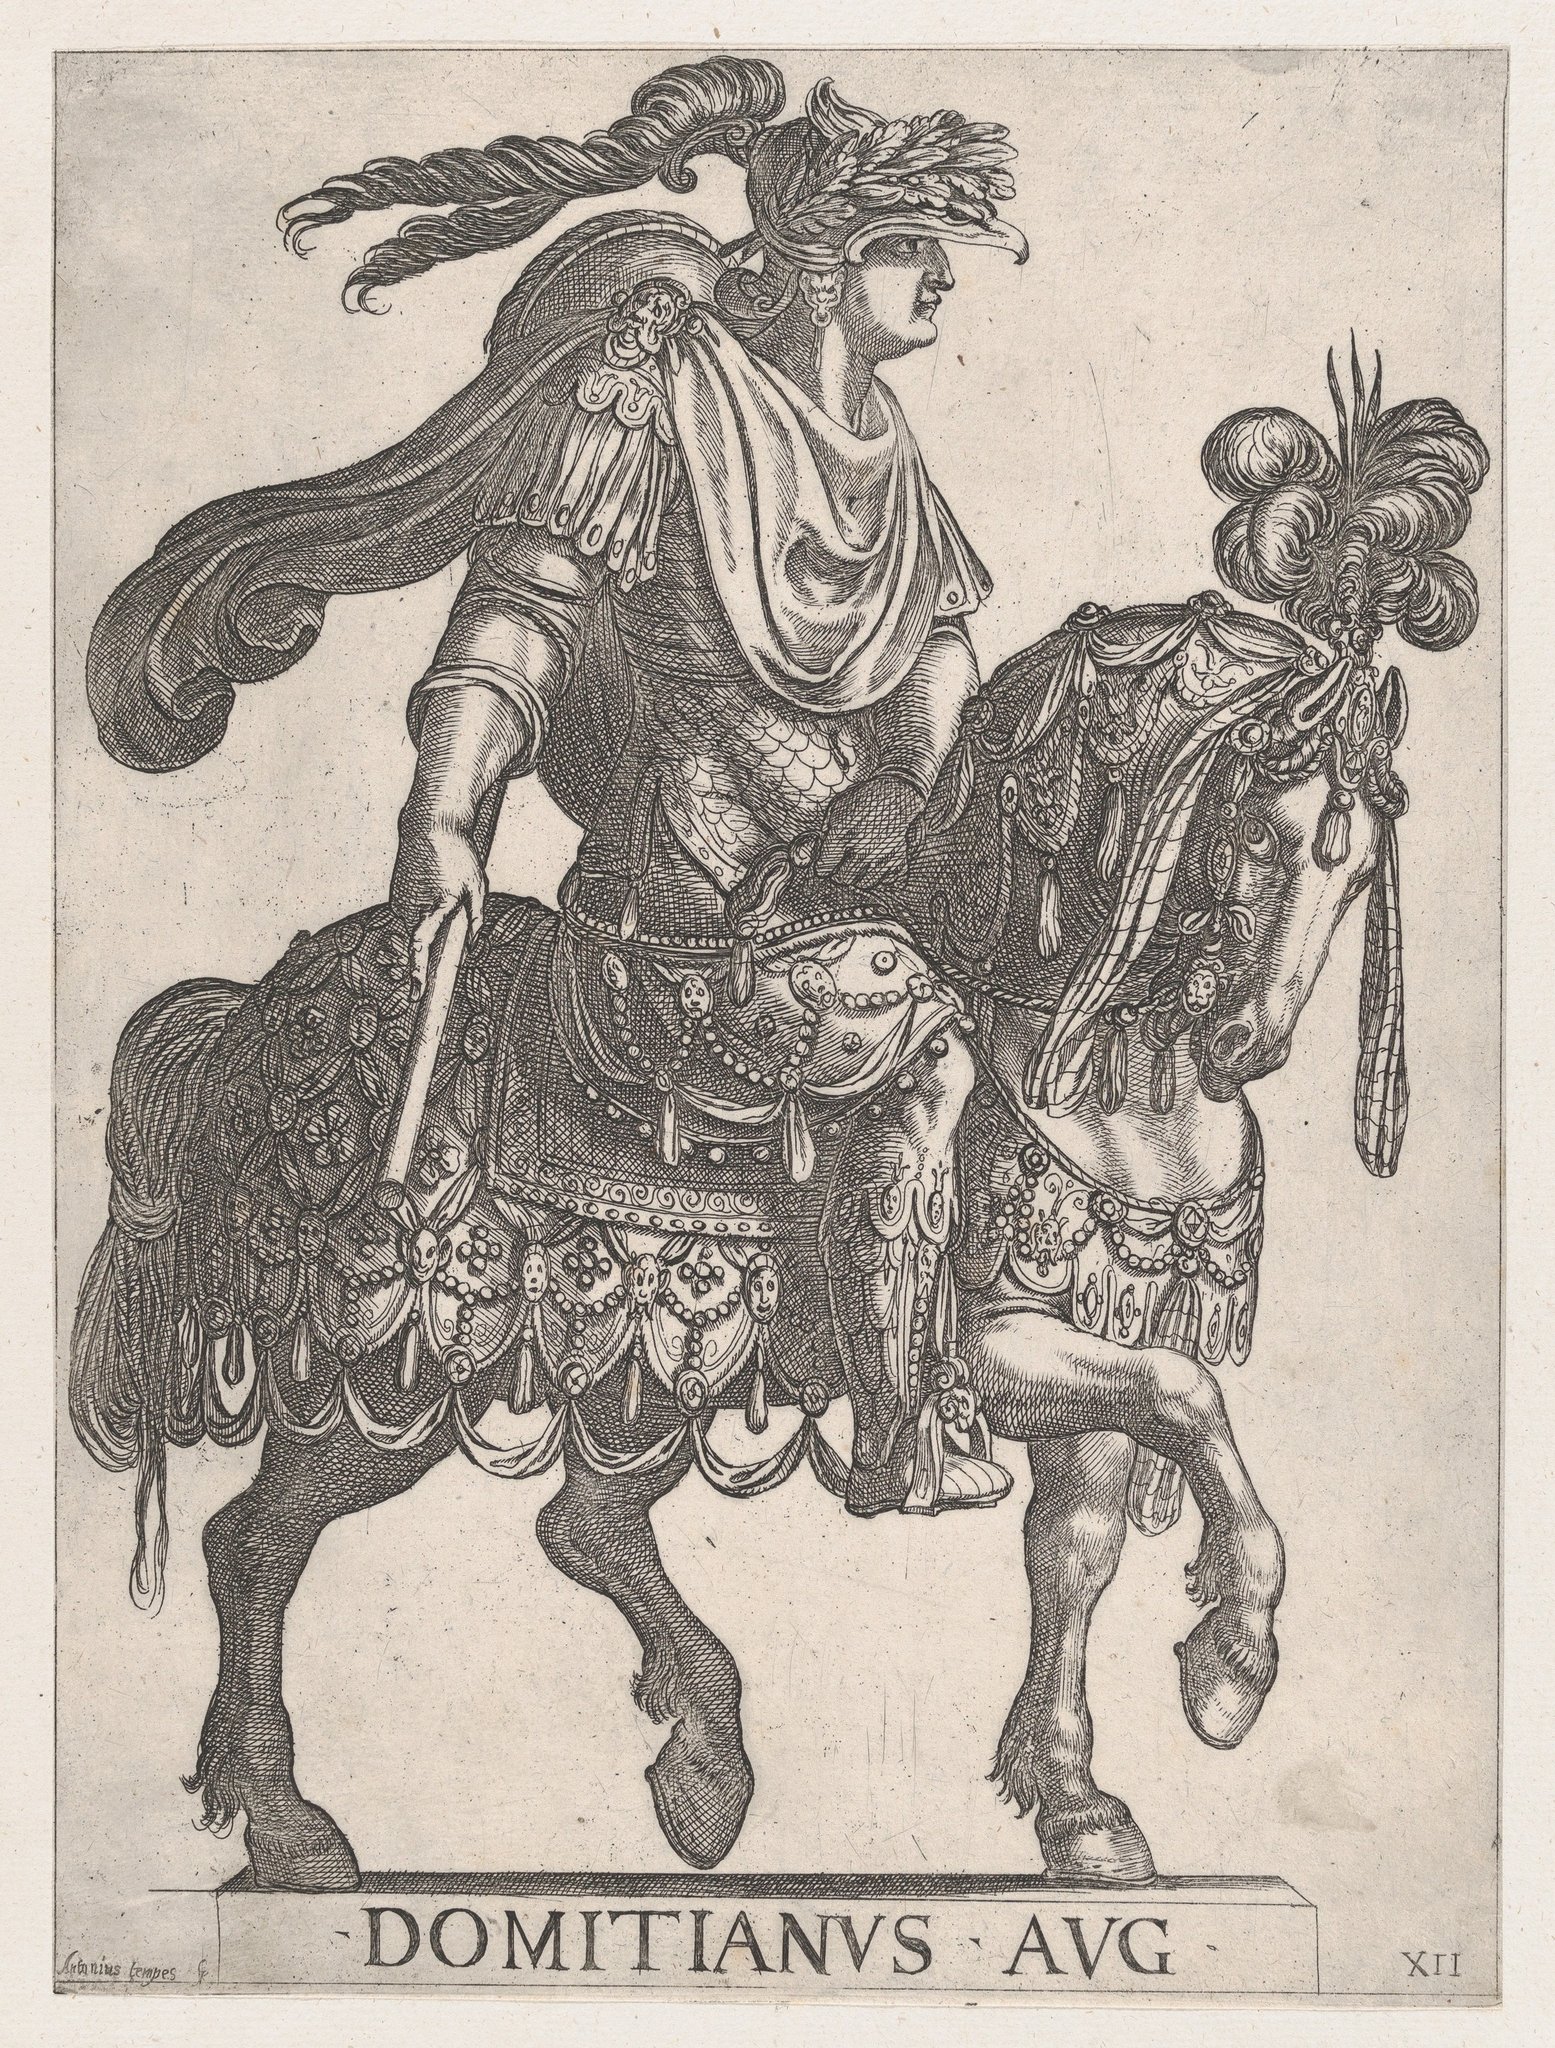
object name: print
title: Plate 12: Emperor Domitian on horseback facing right from the 'First Twelve Emperors of Ancient Rome'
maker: antonio tempesta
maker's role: artist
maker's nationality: italian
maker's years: 1555-1630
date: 1575-1630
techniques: etching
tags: men,horses